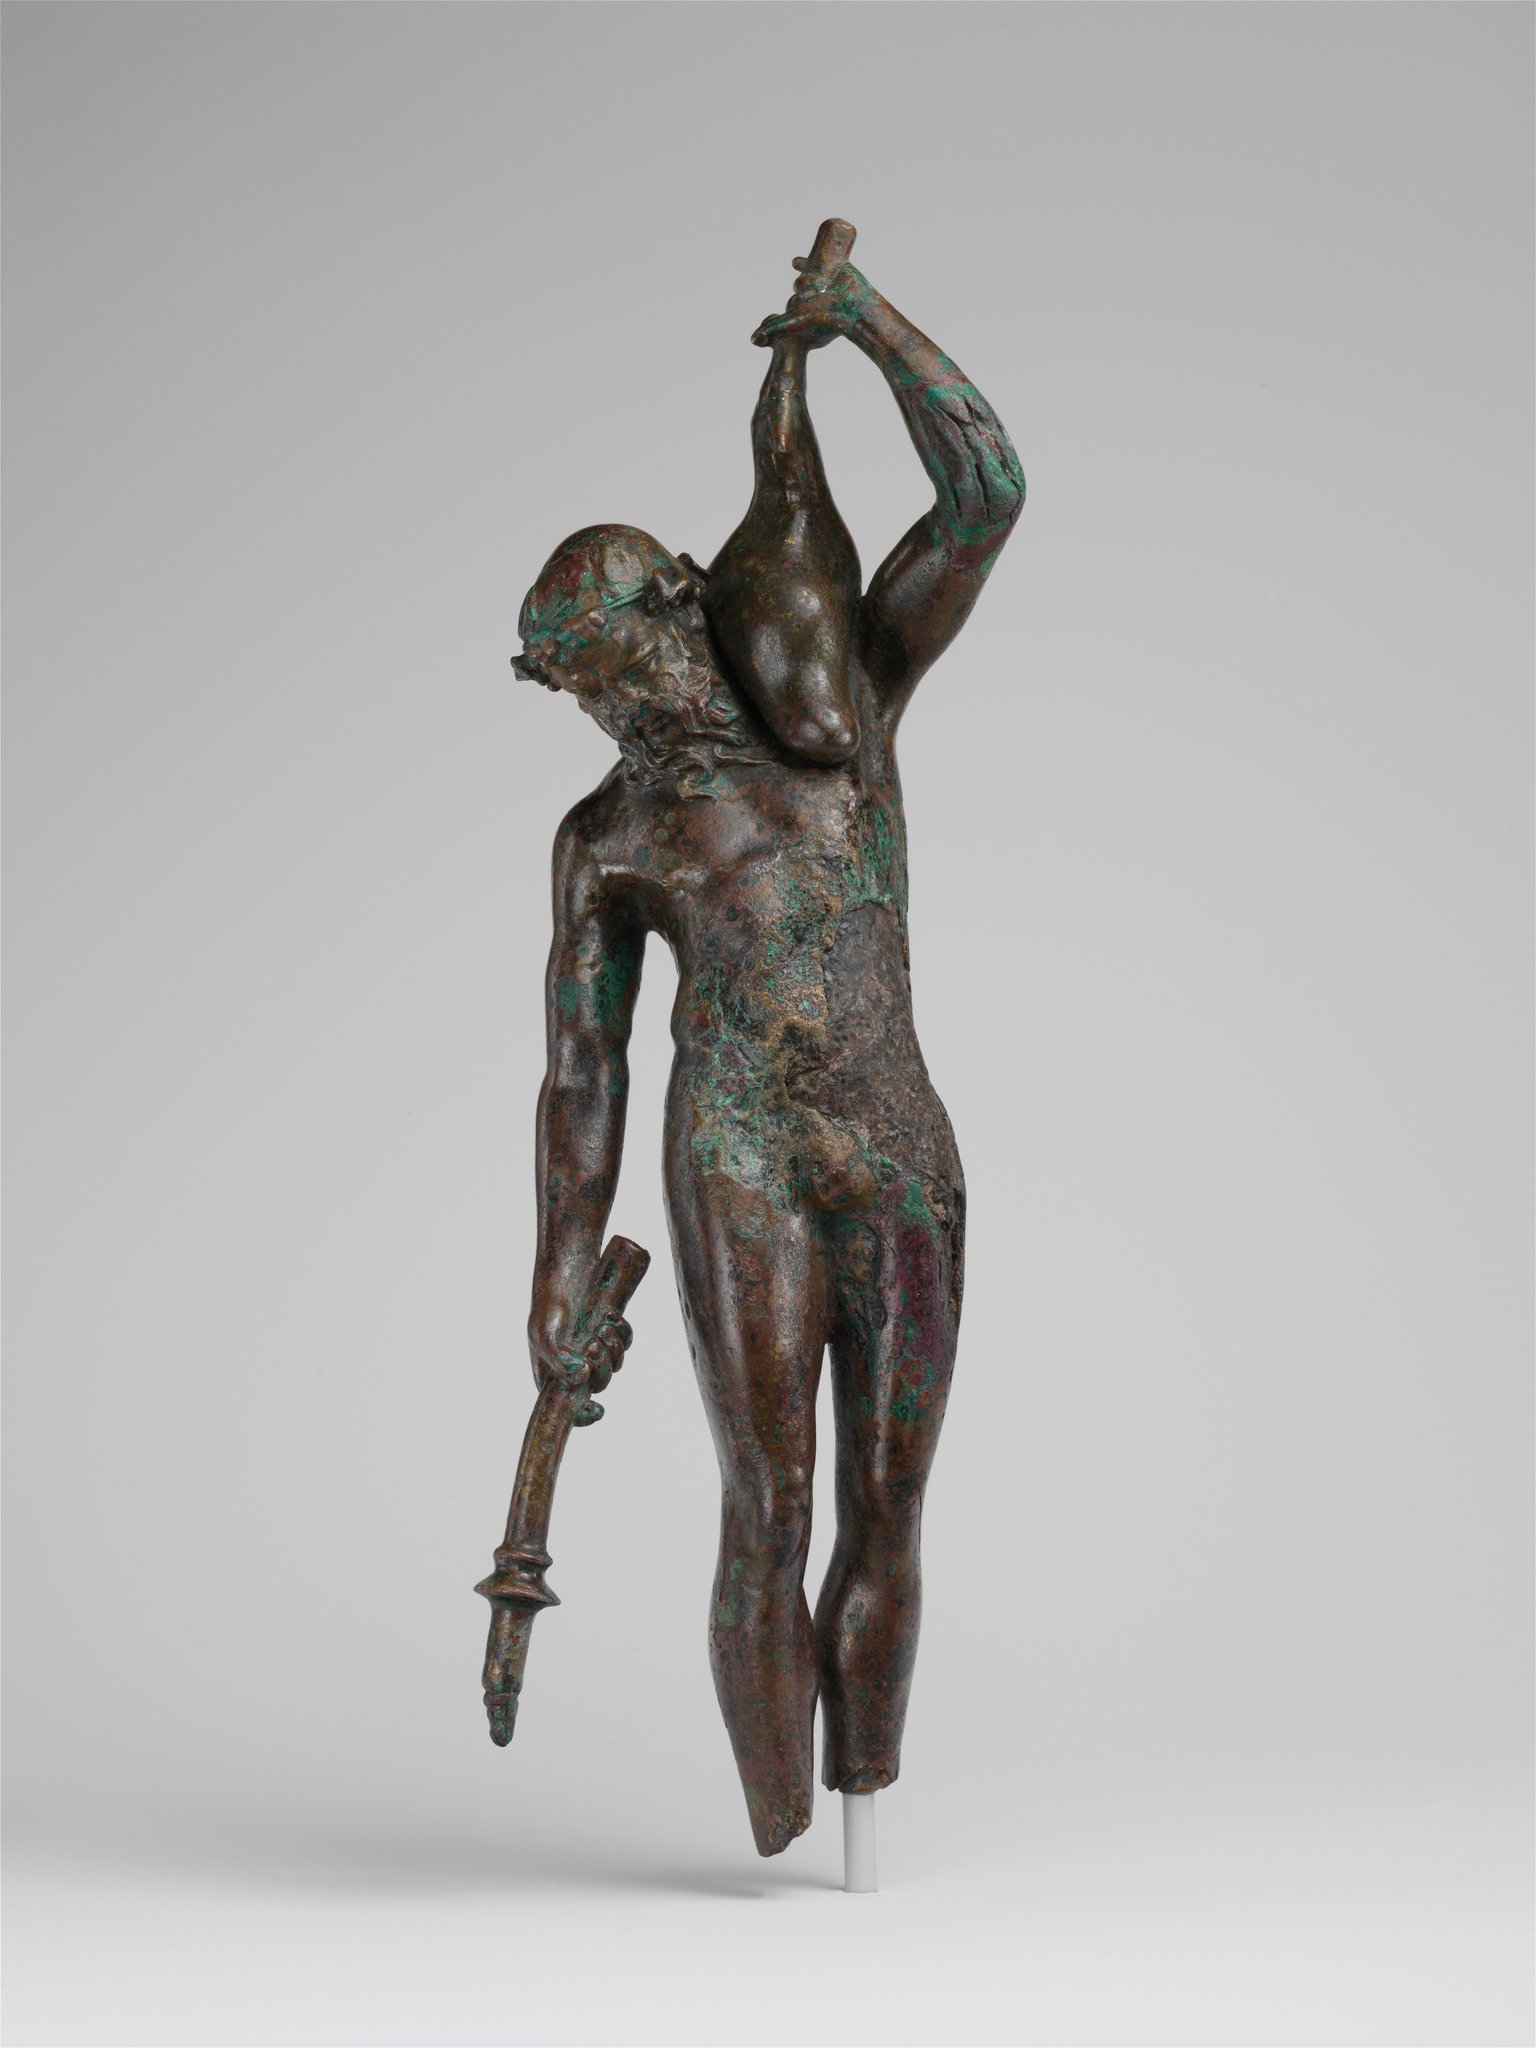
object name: statue of a satyr including a torch and a wineskin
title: Bronze statuette of a satyr with a torch and wineskin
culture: greek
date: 300-101 BCE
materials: bronze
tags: satyrs